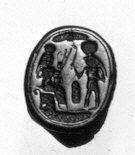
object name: stamp seal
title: Scarab seal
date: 600-501 BCE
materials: jasper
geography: levant or syria